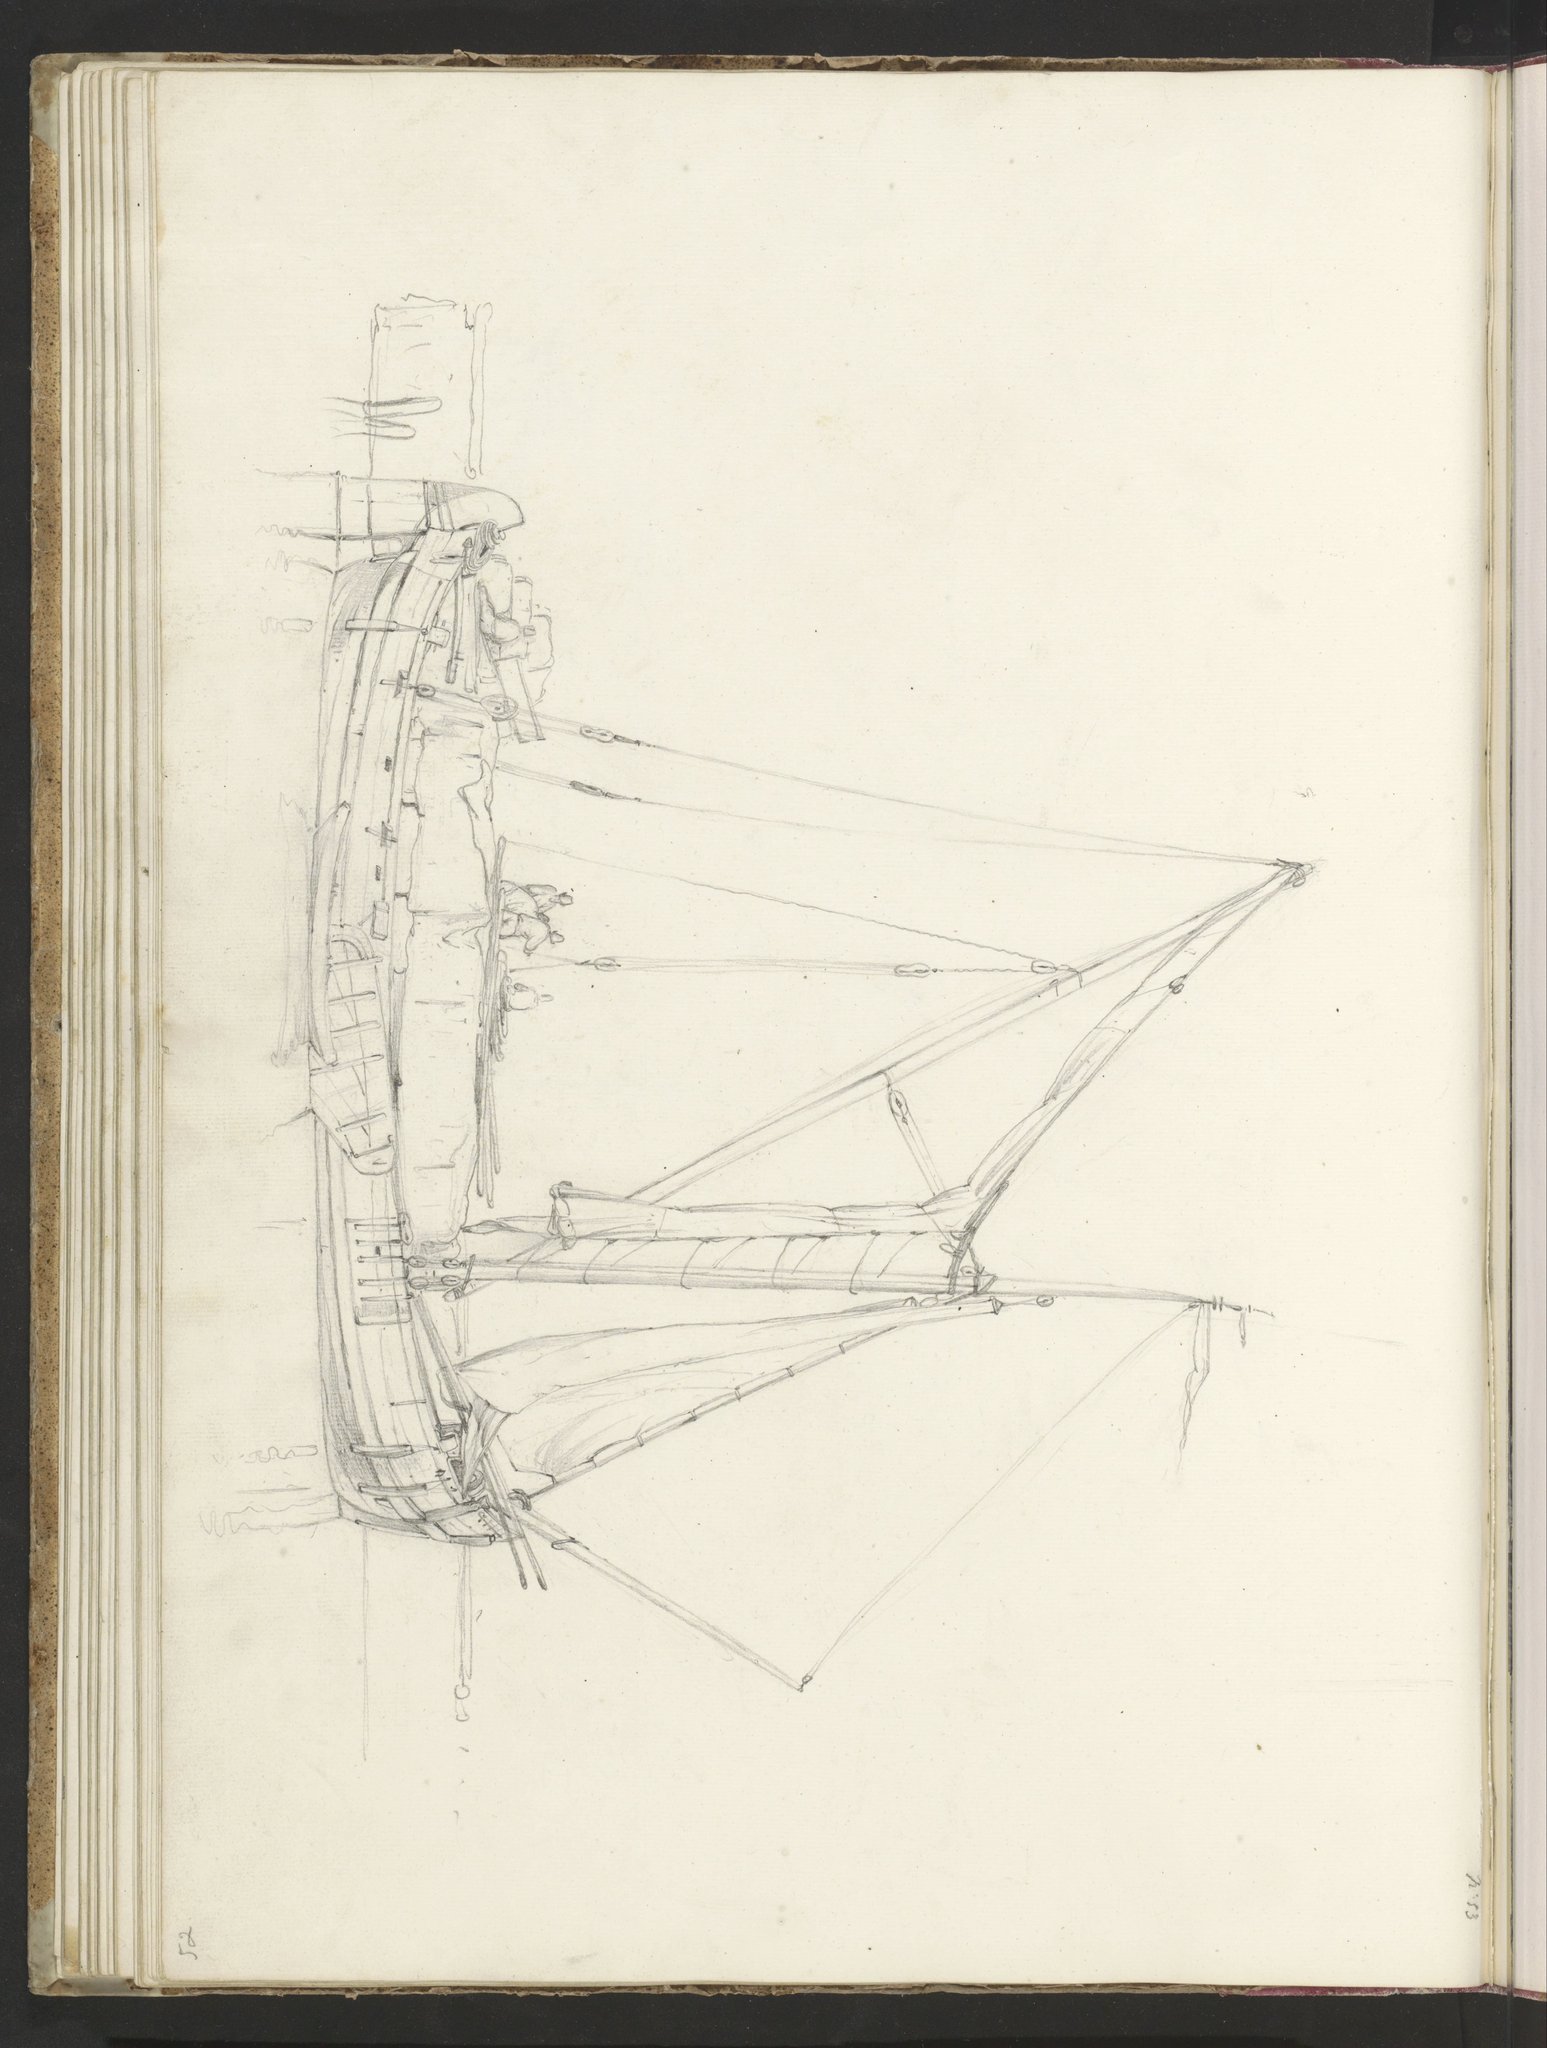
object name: sketchbook leaf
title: Schip bij een overslagkade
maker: johannes christiaan schotel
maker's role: draughtsman, painter, print maker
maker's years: 1787-1838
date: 1797-1838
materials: paper, pencil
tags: freight vessel, pier, quay, wharf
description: Met een takel wordt hout in het schip geladen. Blad 52 verso uit een schetsboek met 65 bladen.